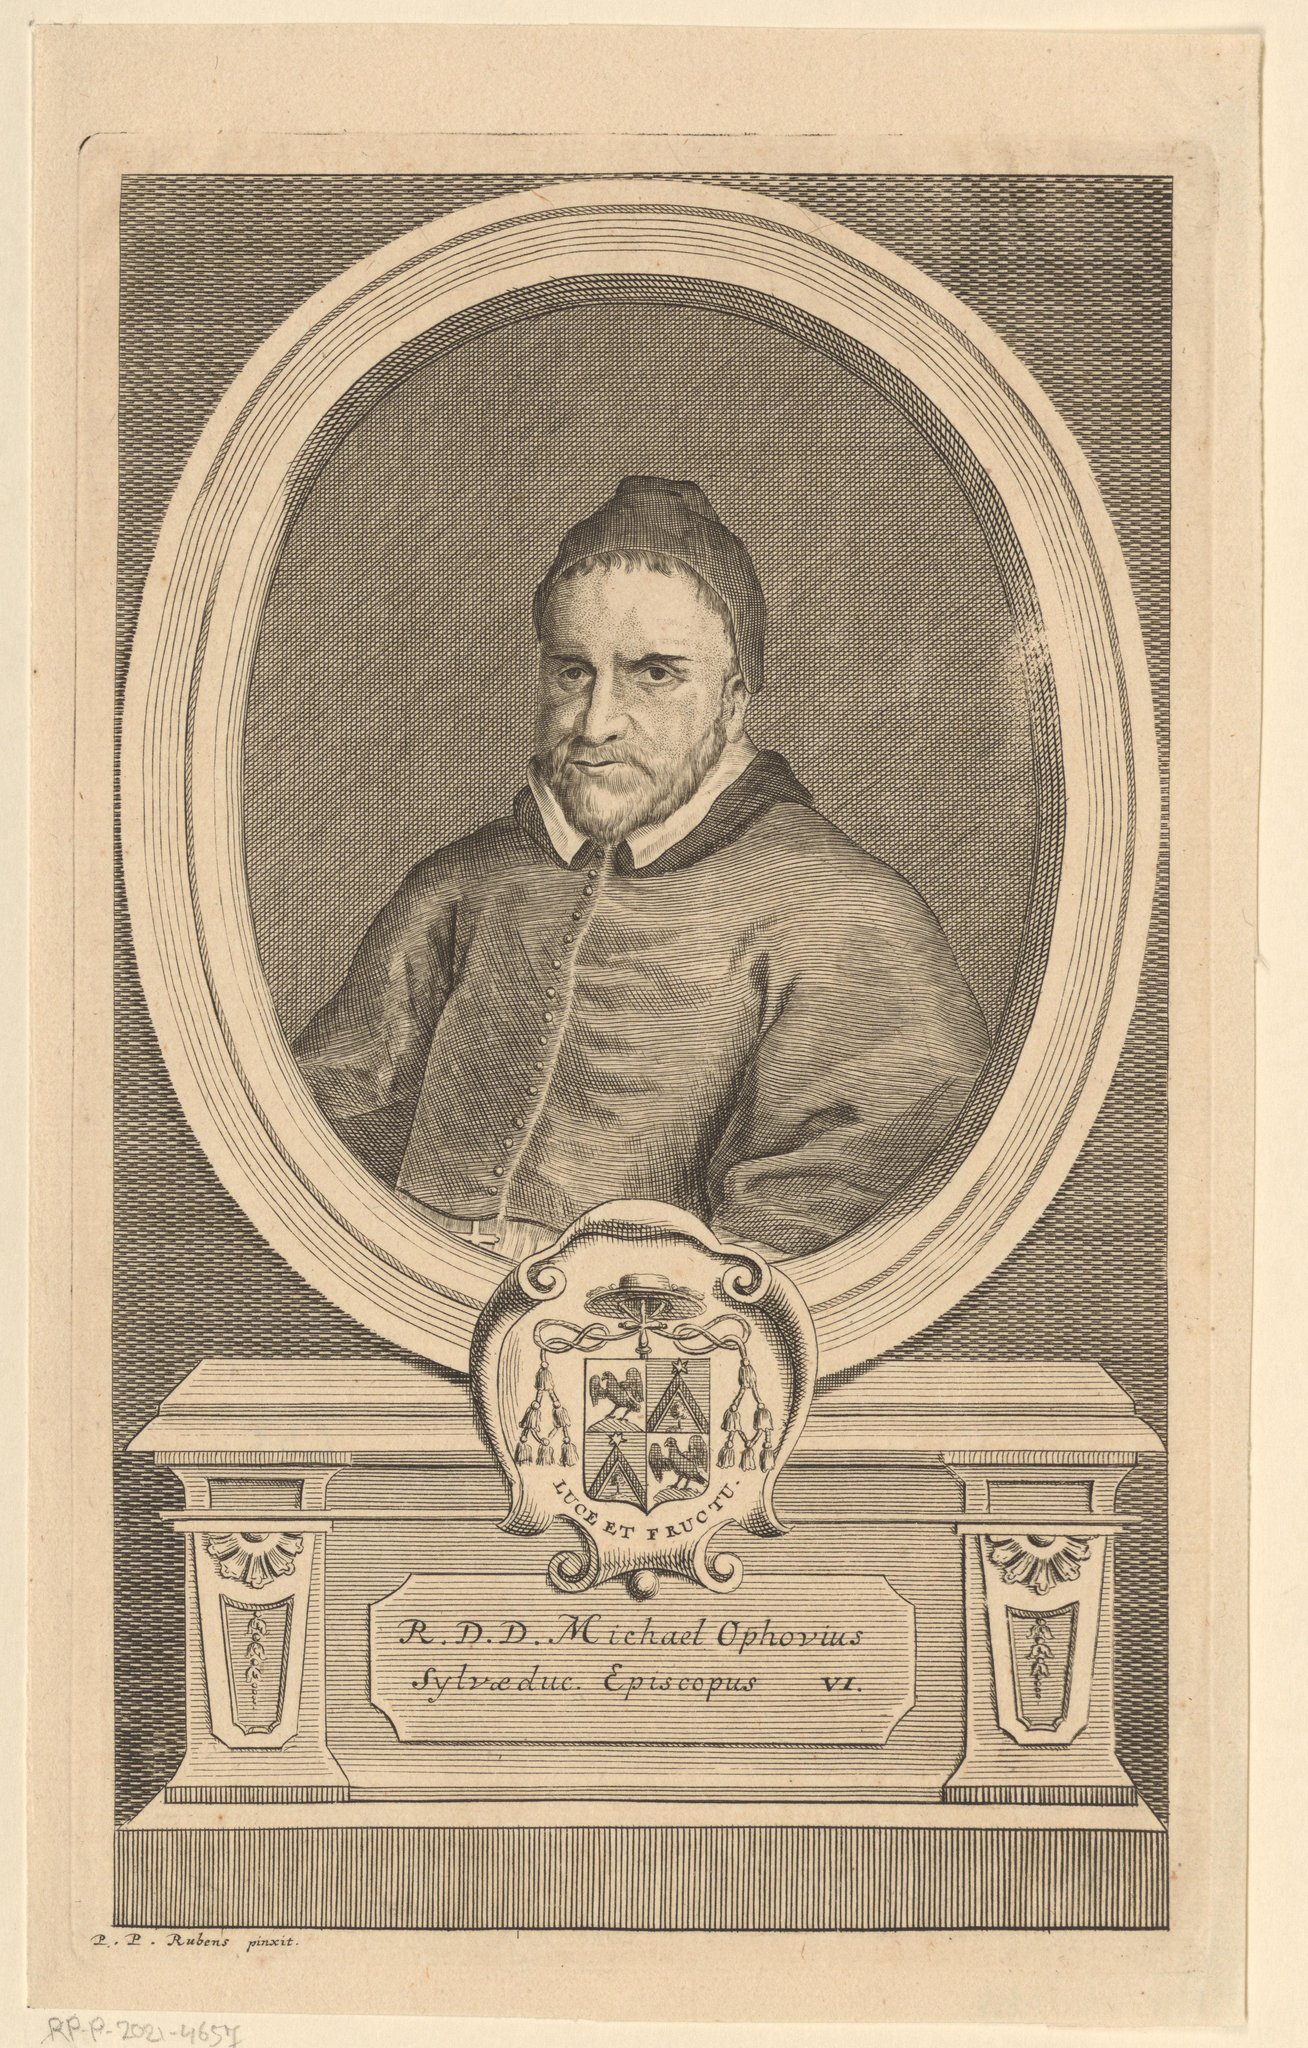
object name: print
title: Portret van Michael Ophovius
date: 1700-1749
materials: paper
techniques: engraving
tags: den bosch, lierre, michael ophovius, historical persons, armorial bearing, heraldry